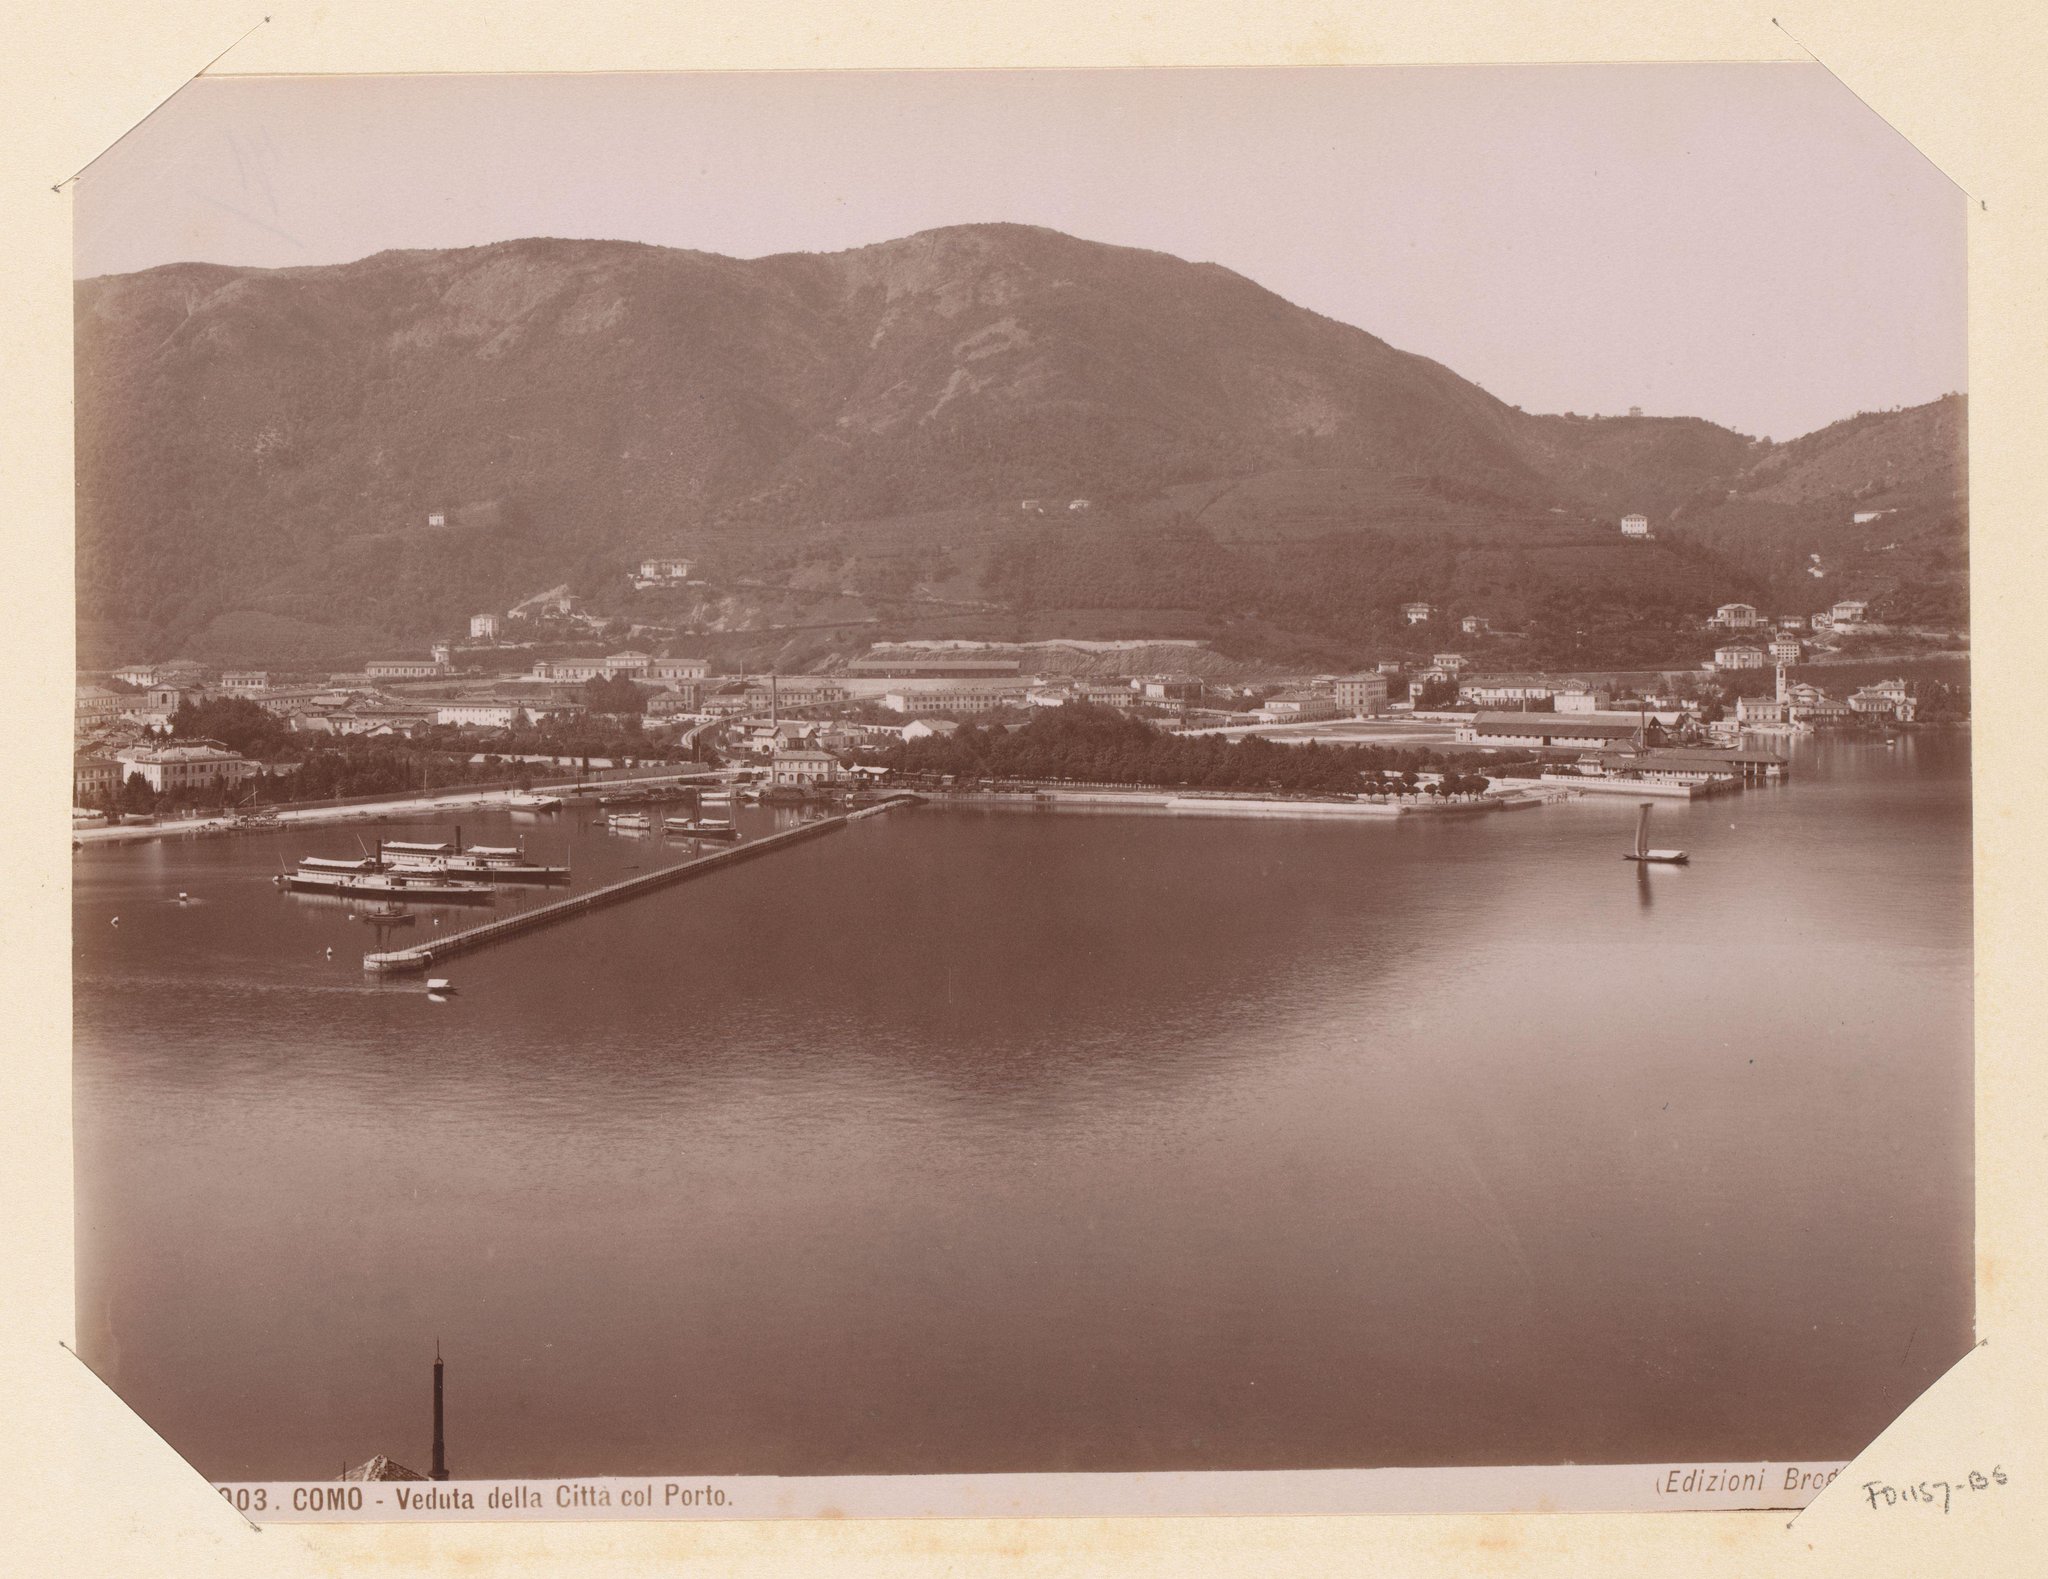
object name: photograph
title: Gezicht op het Comomeer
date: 1885-1892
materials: photographic support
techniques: albumen print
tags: lake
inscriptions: number: ‘9003’, annotation: ‘Meer van Como’